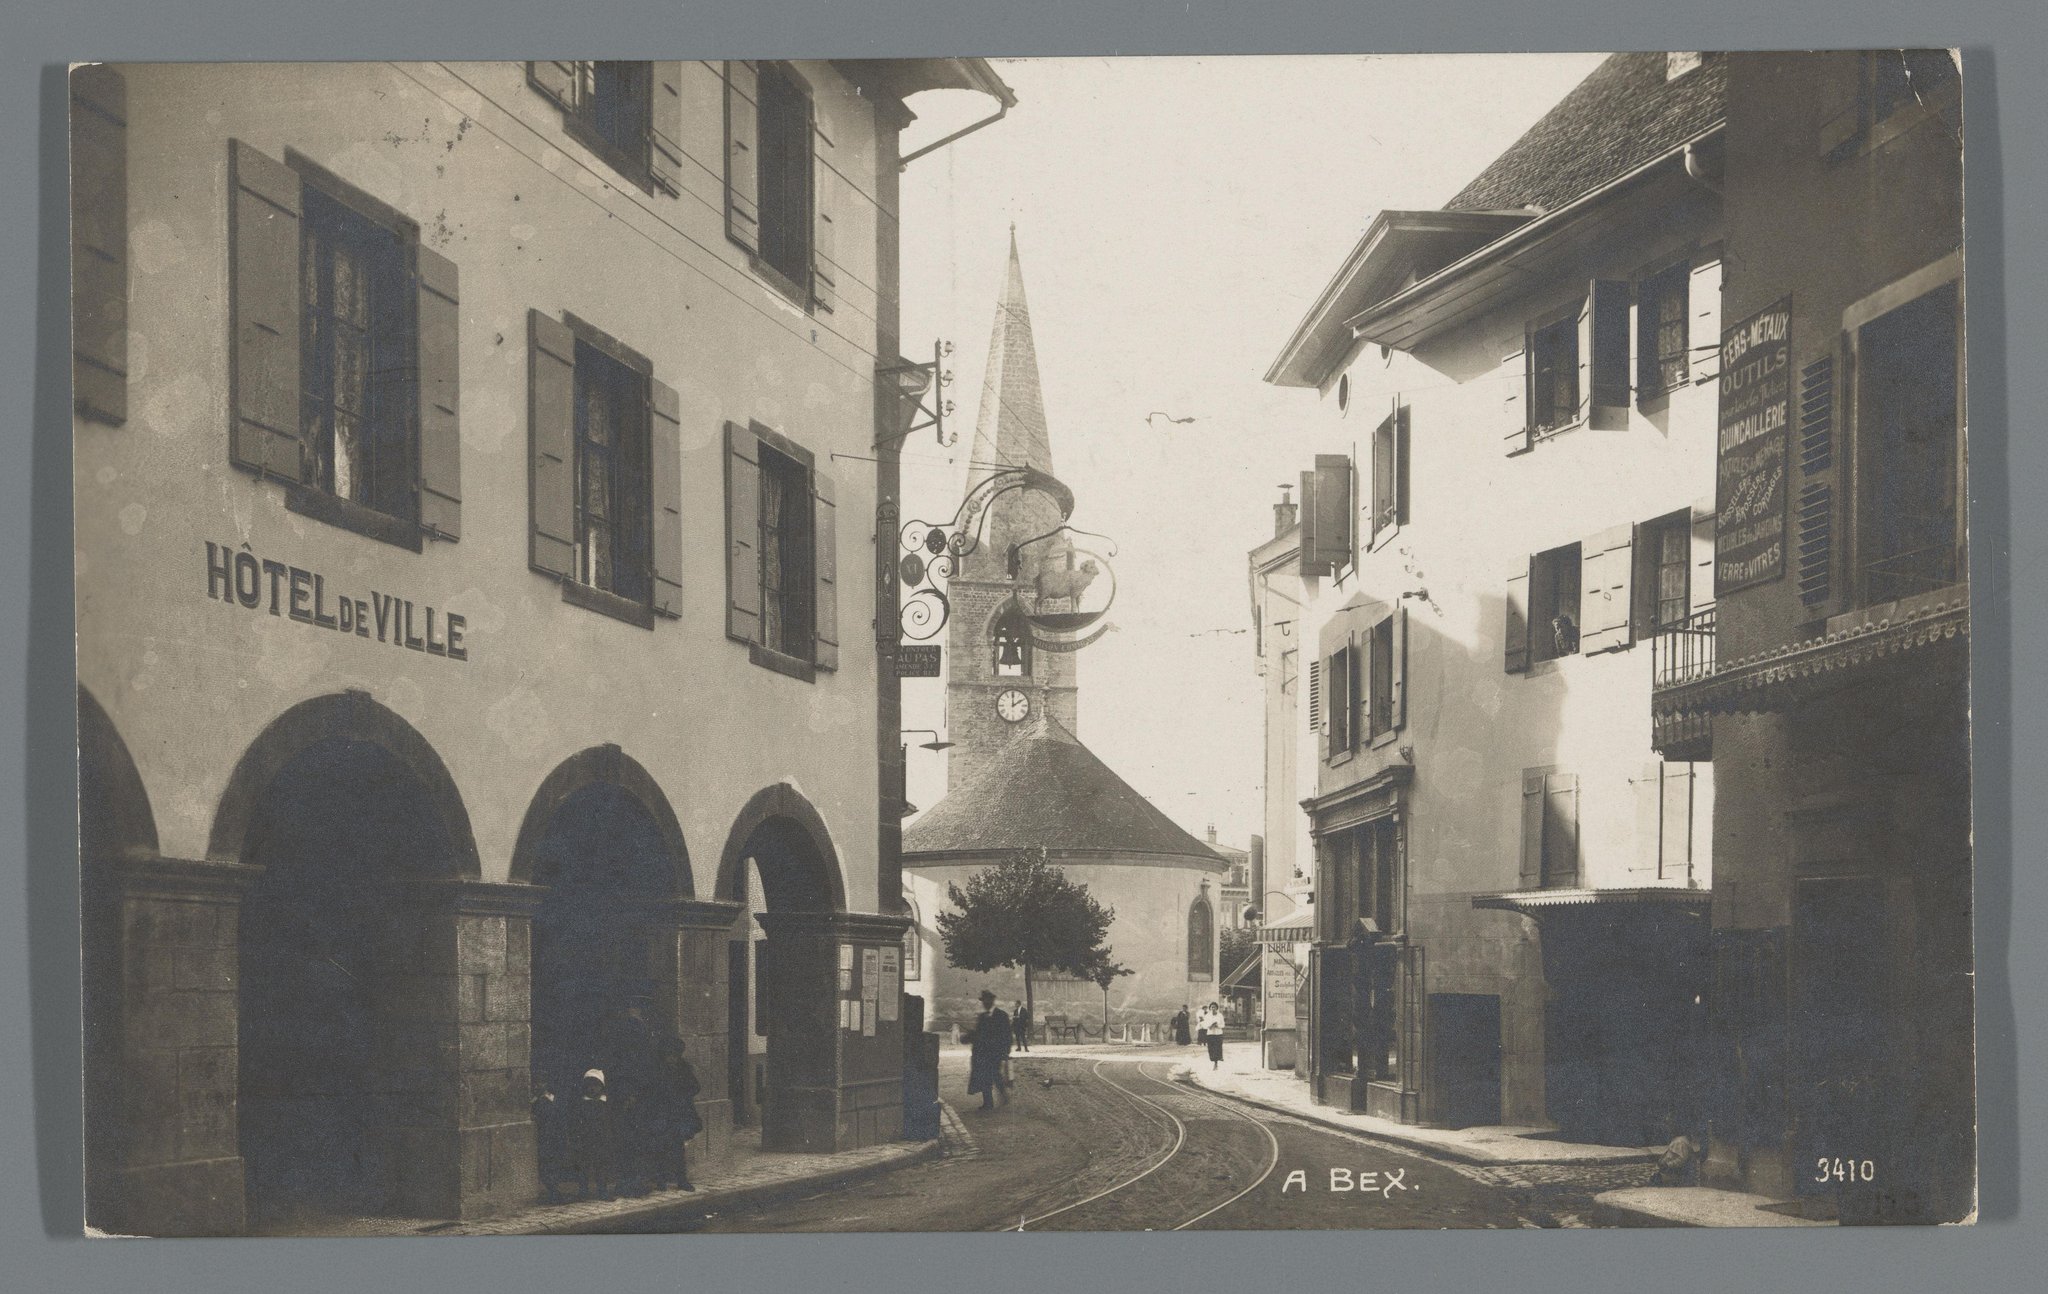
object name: postcard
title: Zuizerland, Bouwkunst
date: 1920-1950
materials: photographic support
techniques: gelatin silver print